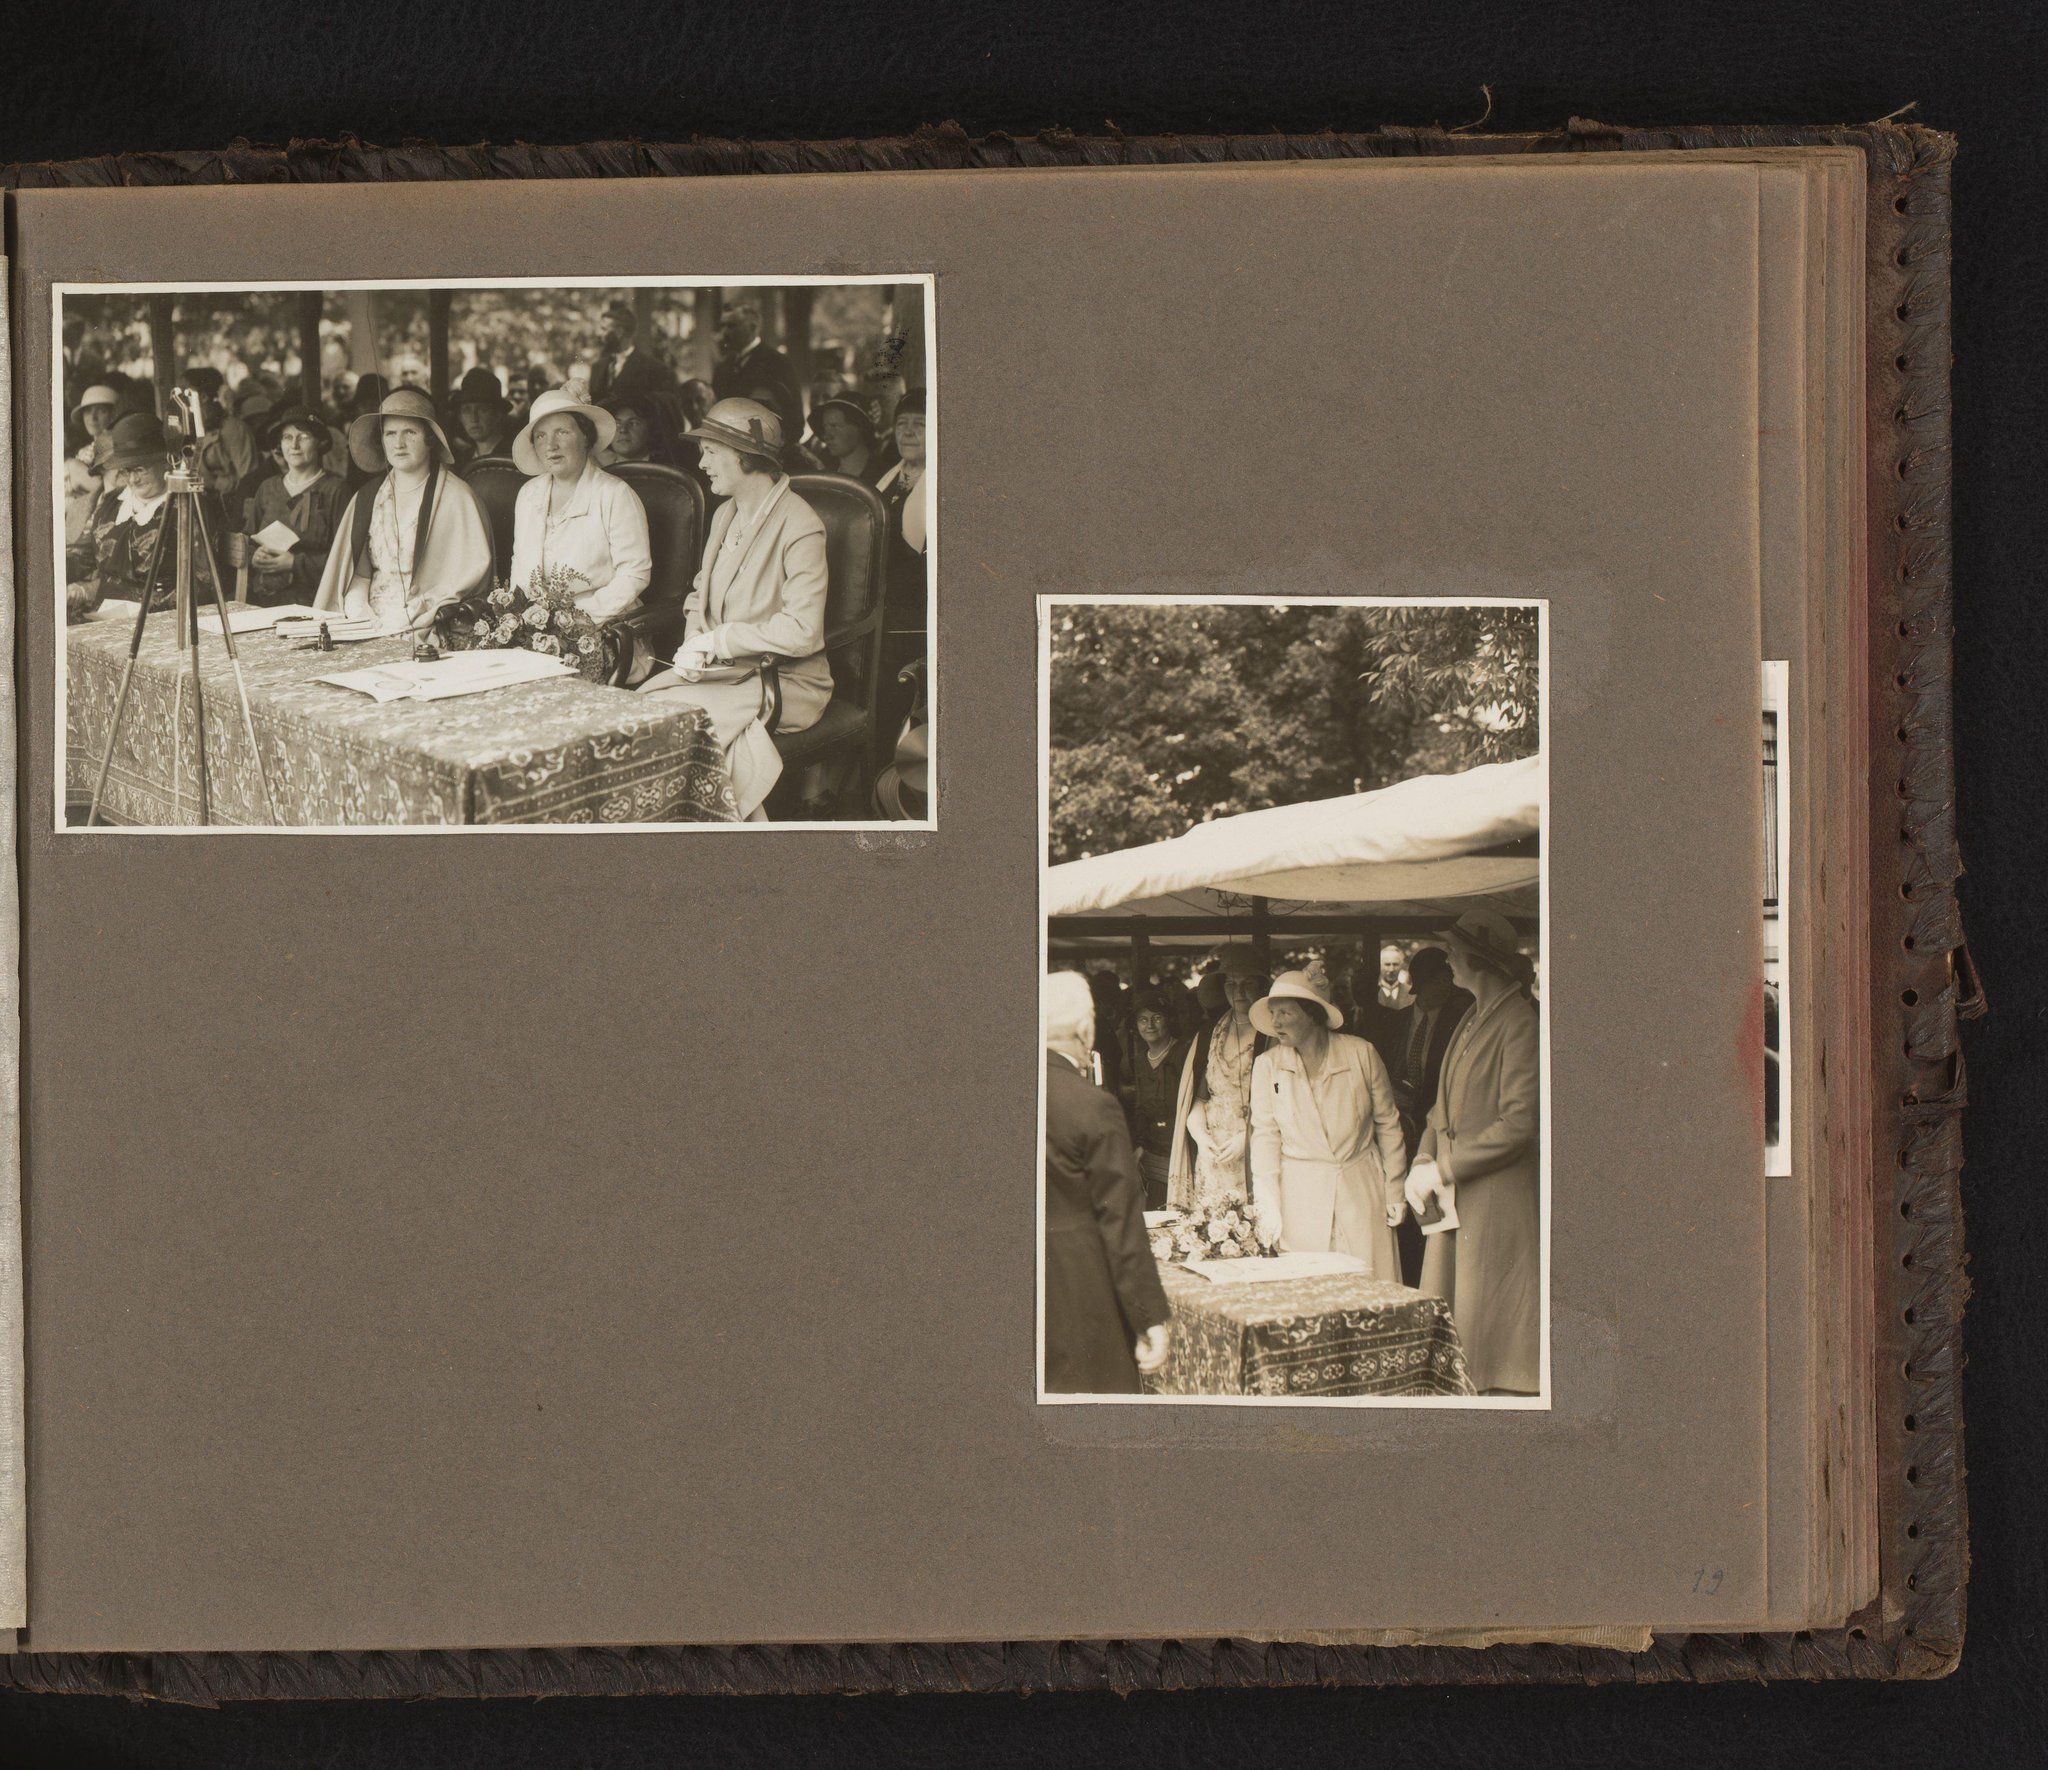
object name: photograph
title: Twee foto's van prinses Juliana bij een plechtigheid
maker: Anonymous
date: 1930-1936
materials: paper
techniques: gelatin silver print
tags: juliana of the netherlands, adult woman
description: Deze foto's maken deel uit van een album.